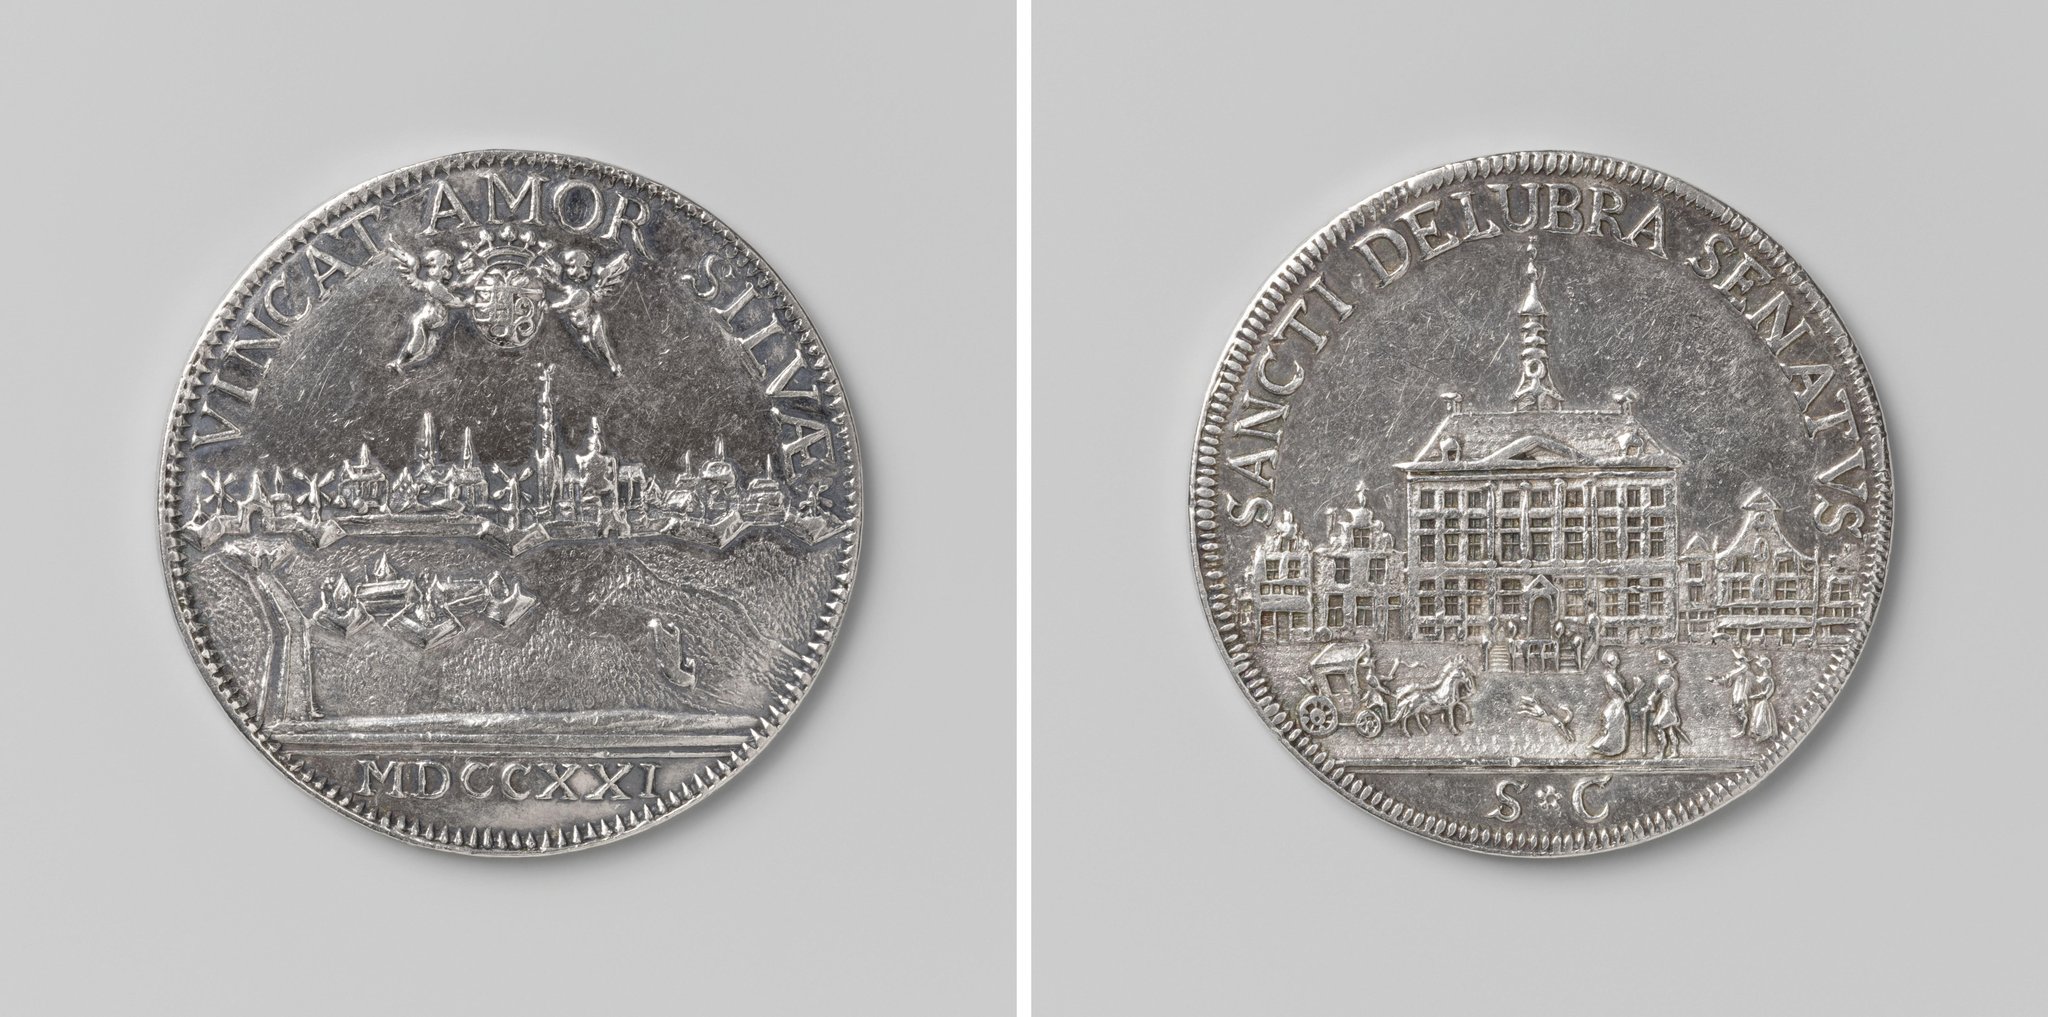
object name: council medal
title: Vroedschapspenning van de stad 's-Hertogenbosch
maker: theodorus casparus van berckel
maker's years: 1680-1734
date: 1721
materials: silver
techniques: striking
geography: den bosch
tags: den bosch